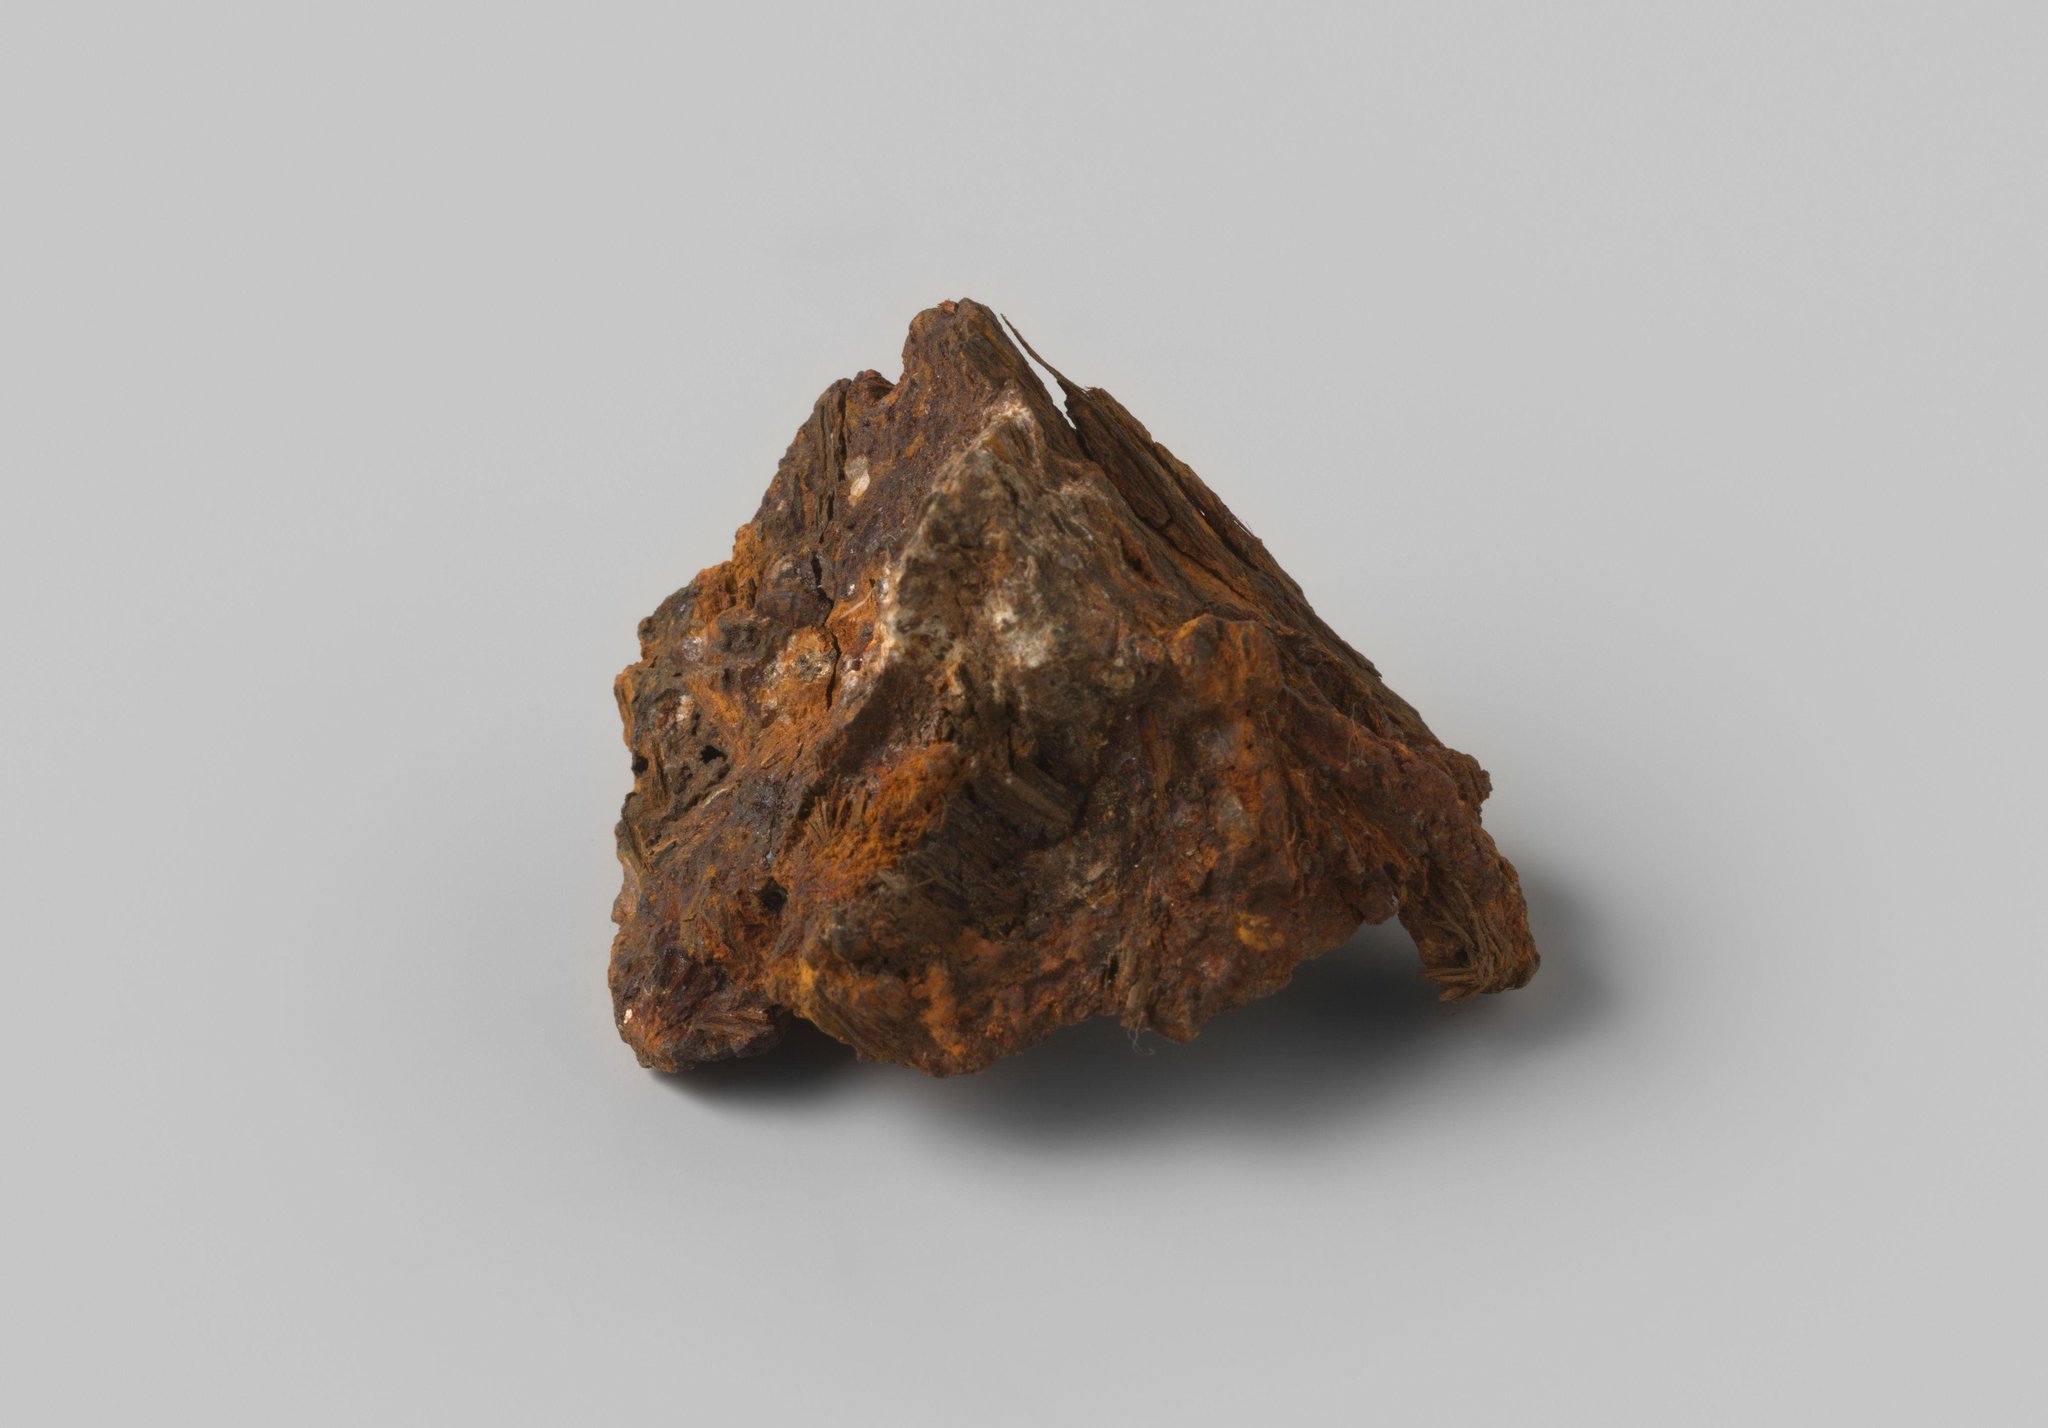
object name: concretionary stone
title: Concretie van een gewicht uit het wrak van de Oost-Indiëvaarder Hollandia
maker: Anonymous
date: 1700-1743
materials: stone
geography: netherlands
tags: verenigde oostindische compagnie, hollandia (schip), annet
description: Concretie behorend bij een gewicht uit het wrak van de Oostindiëvaarder Hollandia.